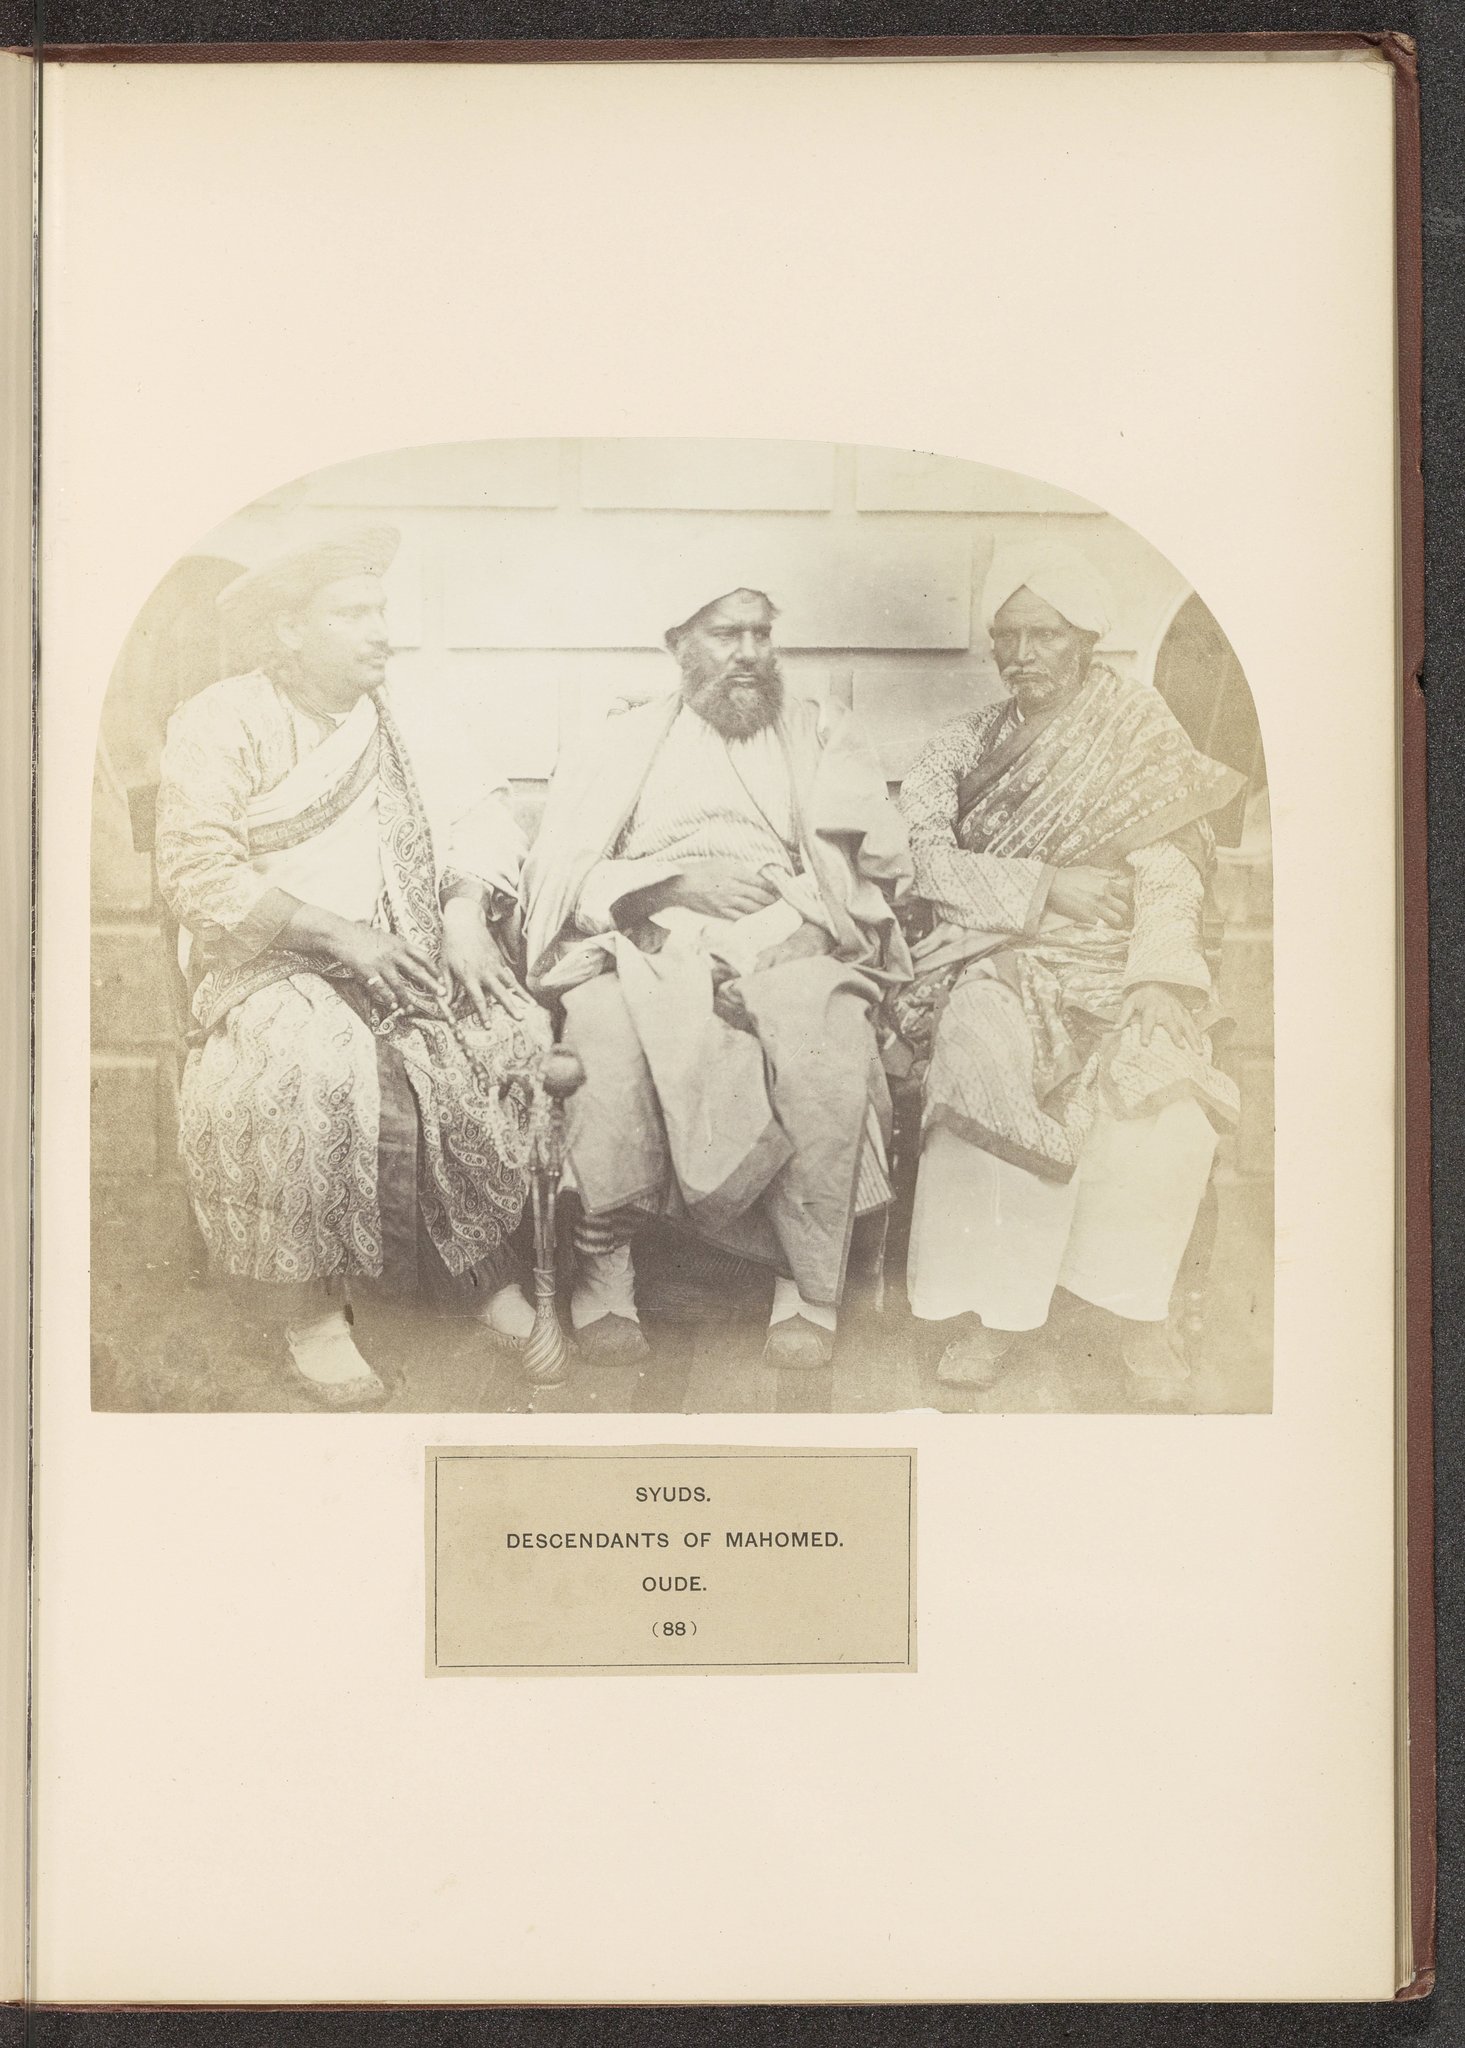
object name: page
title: Portrait of three men from the Sayyid community of Awadh, Uttar Pradesh, India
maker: Anonymous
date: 1858-1868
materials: photographic support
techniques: albumen print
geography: uttar pradesh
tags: head-gear: turban, human races; peoples; nationalities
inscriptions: inscription: ‘SYUDS./ DESCENDANTS OF MAHOMED./ OUDE.’, number: ‘(88)’